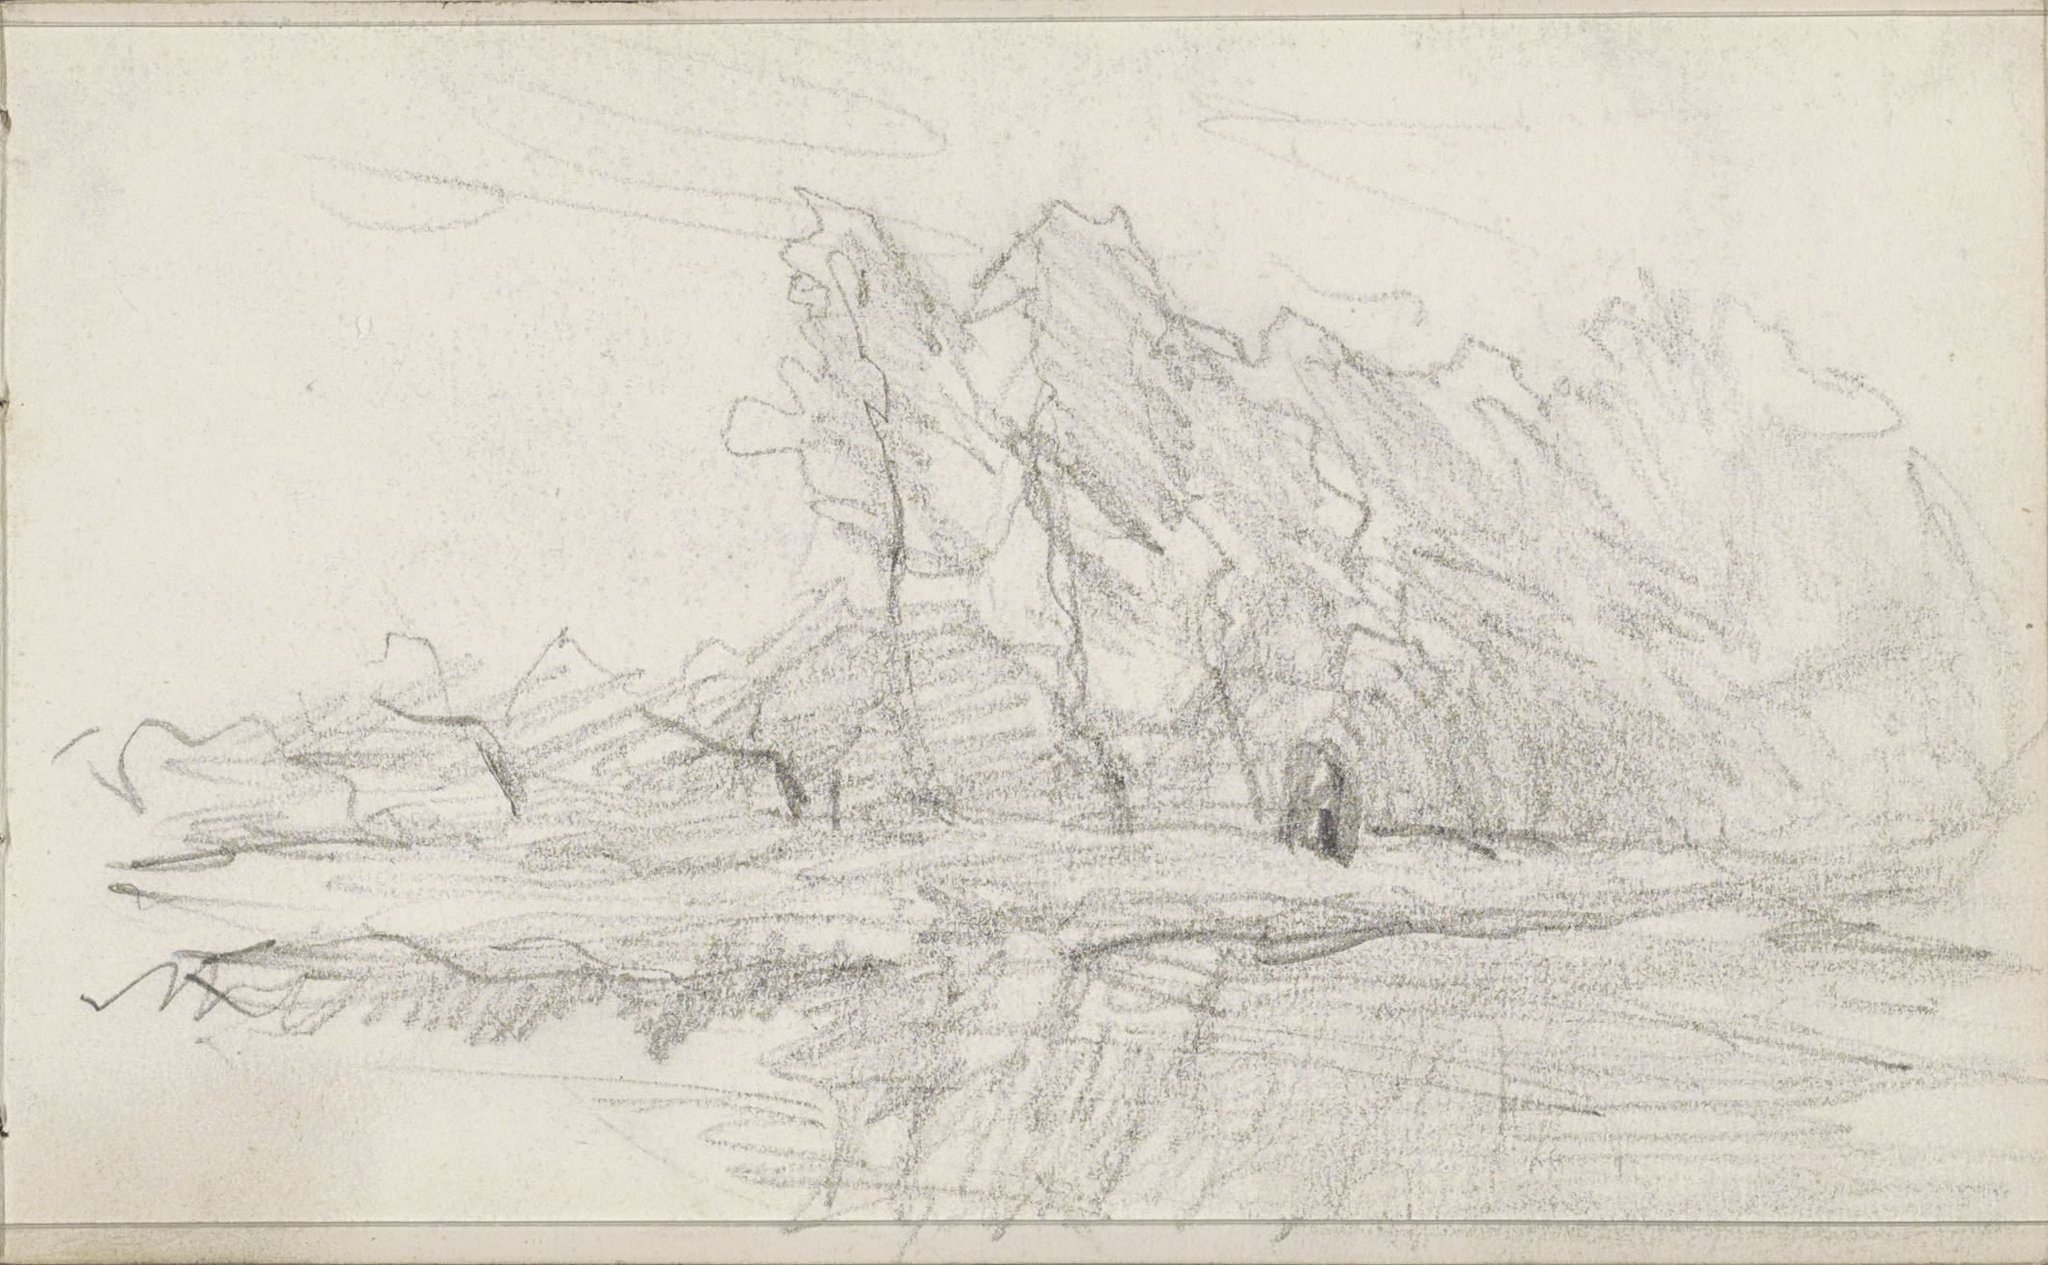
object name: sketchbook leaf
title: Landschap met bomen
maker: anton mauve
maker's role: draughtsman, painter, print maker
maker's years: 1838-1888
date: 1848-1888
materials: paper, pencil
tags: trees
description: Blad 17 recto uit een schetsboek met 43 bladen.